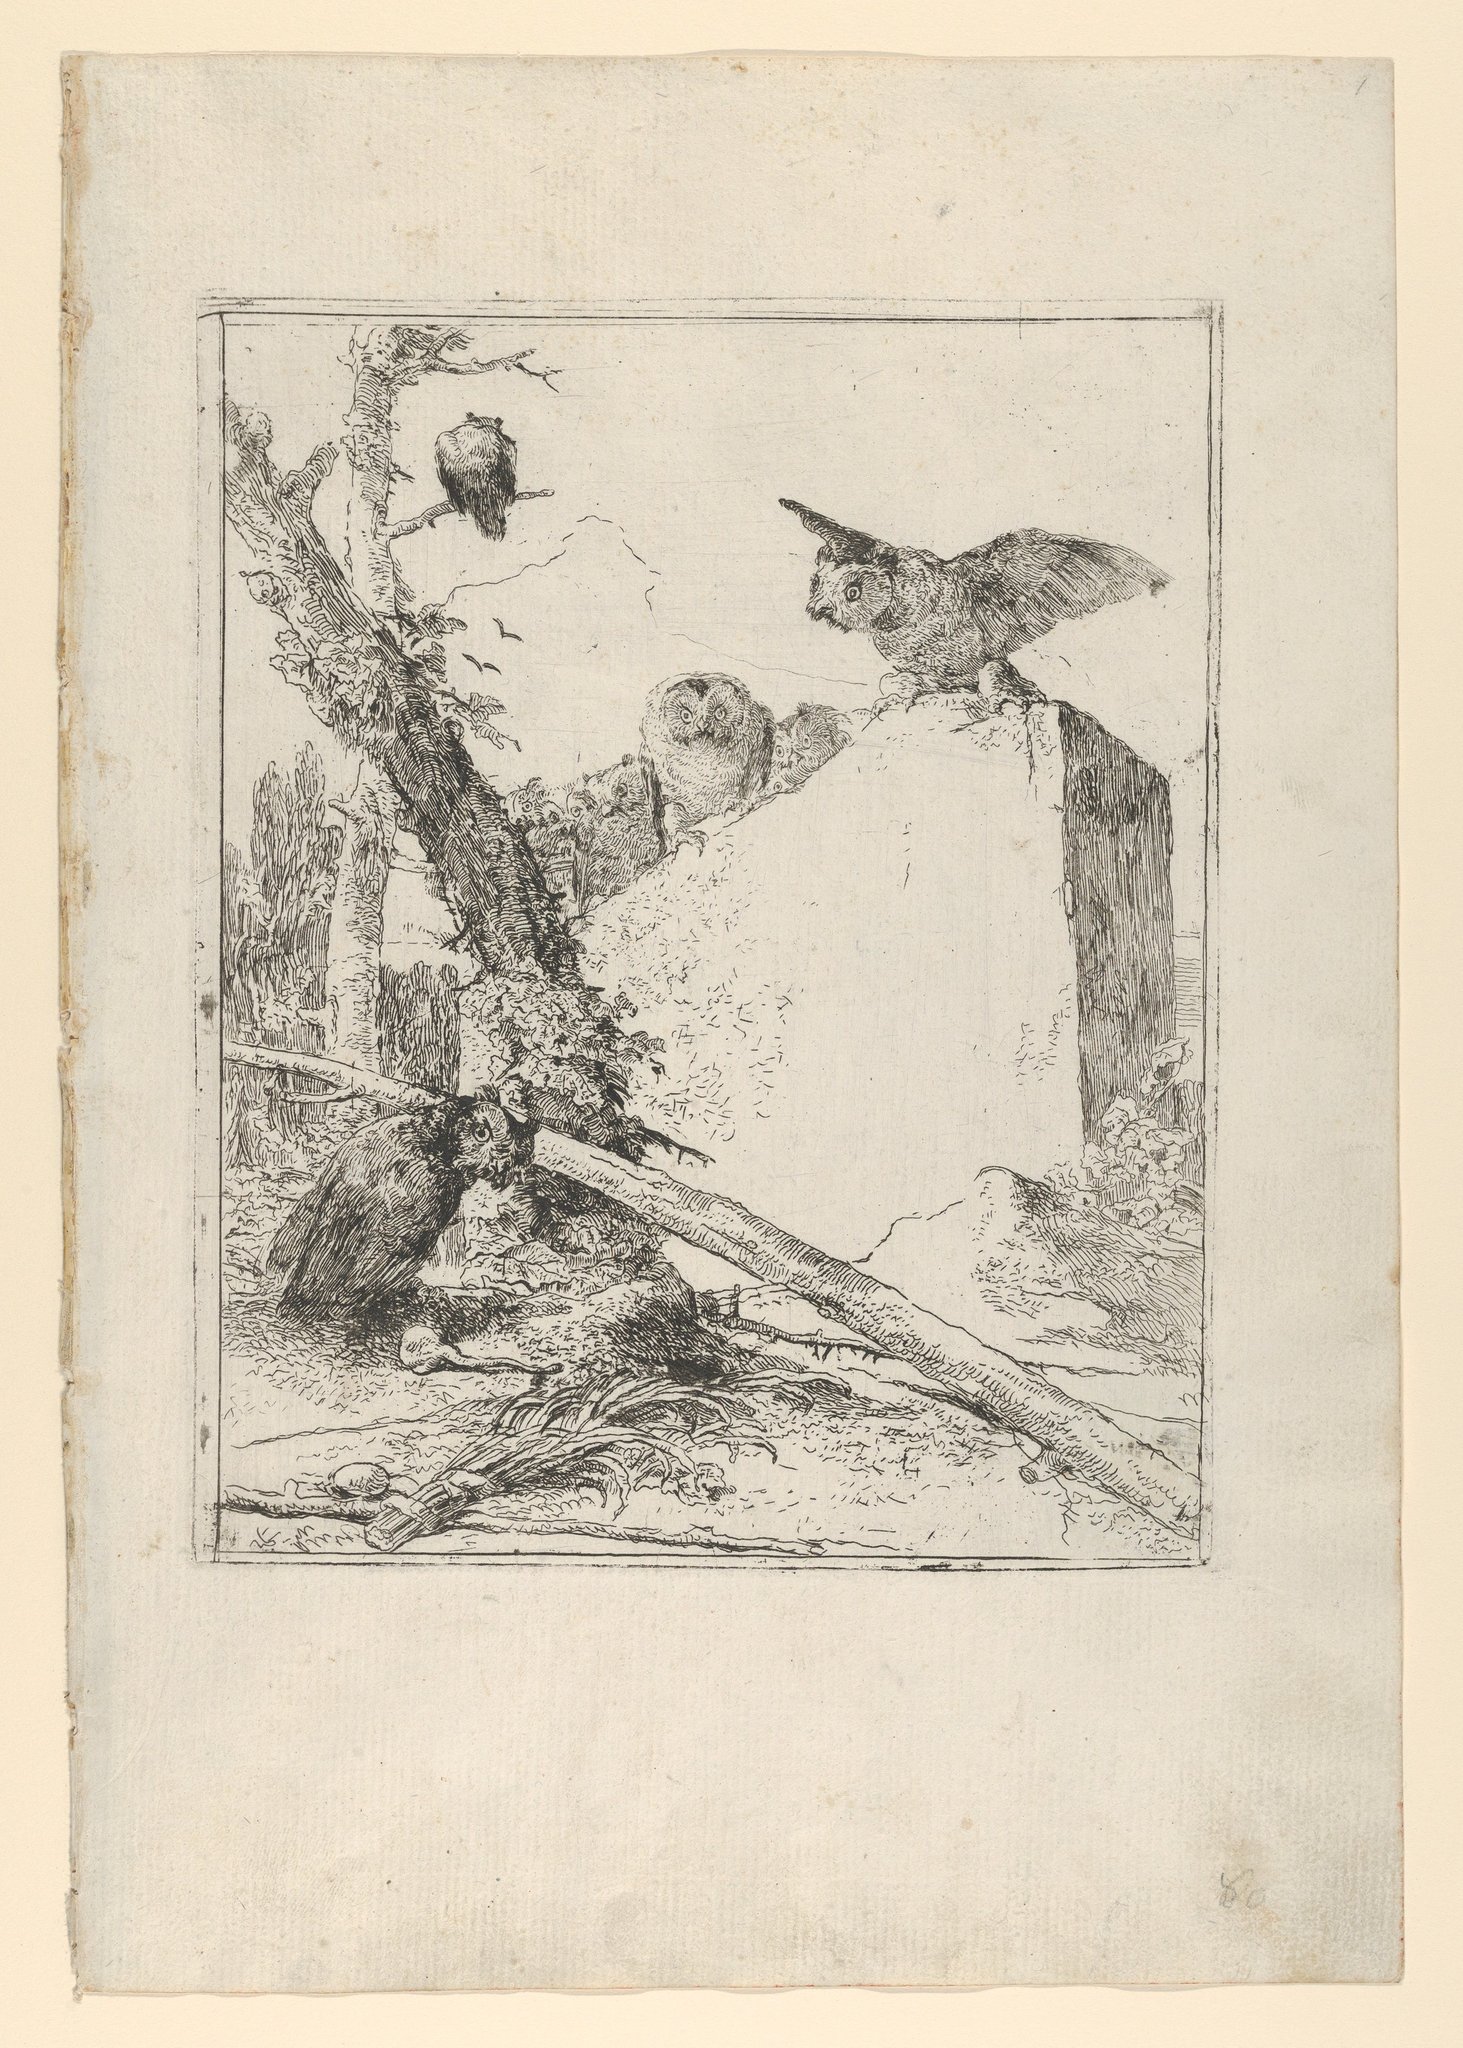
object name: print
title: Frontispiece, from the Scherzi di Fantasia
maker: giovanni battista tiepolo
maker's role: artist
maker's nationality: italian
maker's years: 1696-1770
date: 1743-1750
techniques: etching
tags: owls,trees